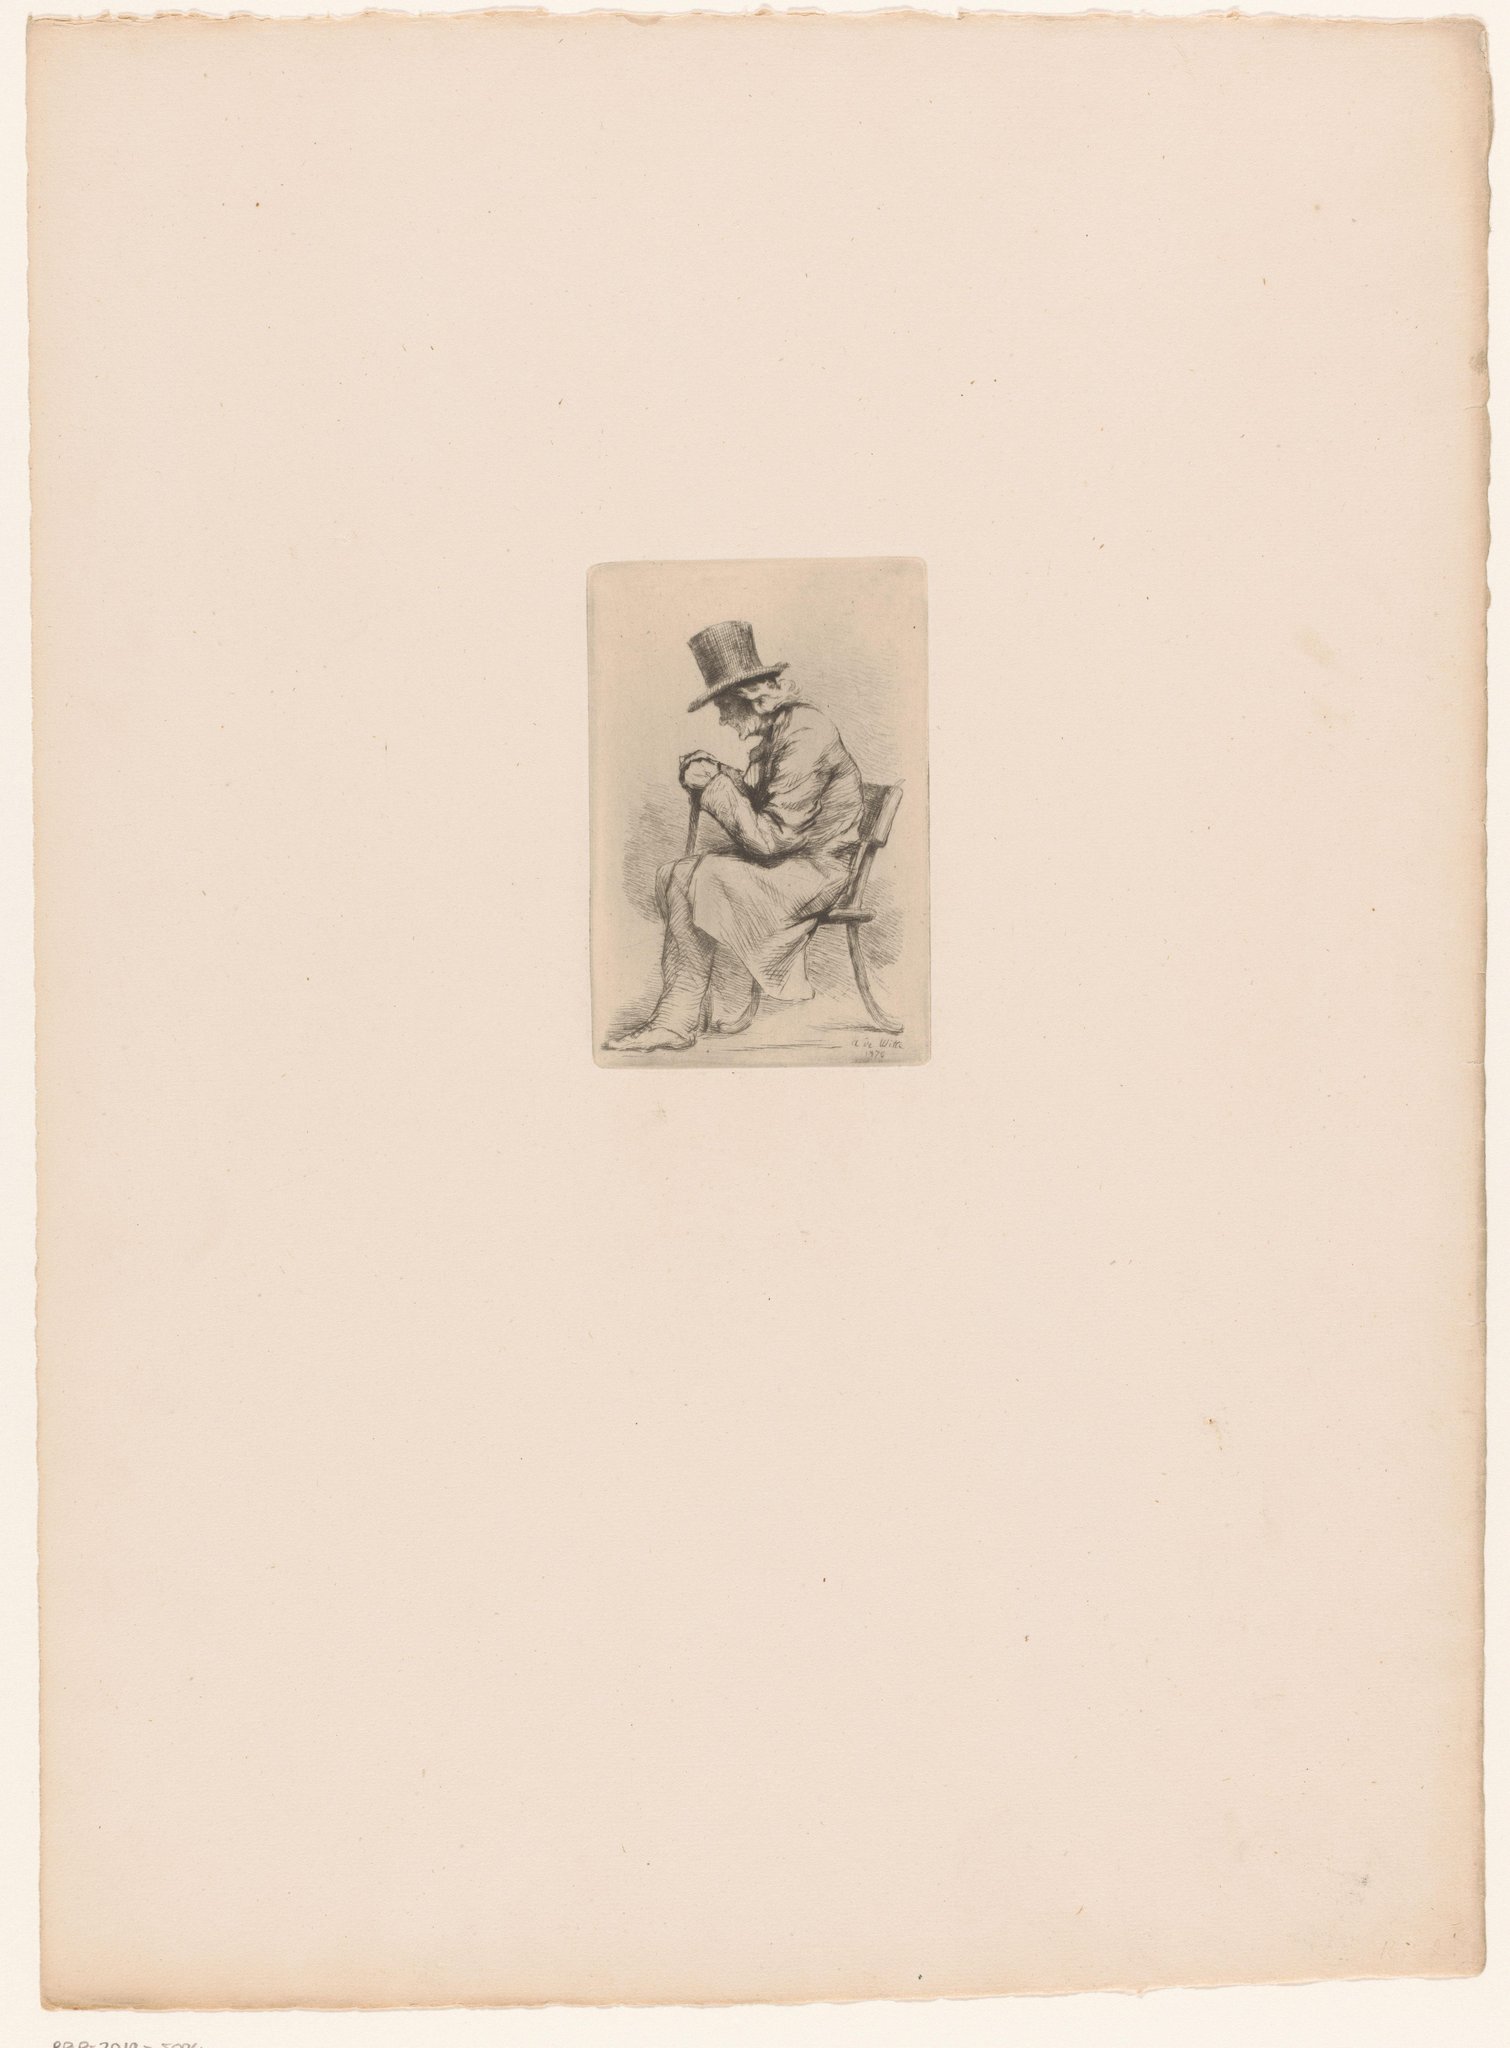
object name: print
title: Oude man met hoed en wandelstok gezeten op een stoel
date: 1875-1876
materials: paper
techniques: drypoint, etching, intaglio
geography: brussels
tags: sitting figure, walking-stick, staff, old man, head-gear: hat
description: Prent uit: Rops, Félicien (red.). Cahier d'études: eaux-fortes originales et inédites. Brussel: Felix Callewaert père, 1875.